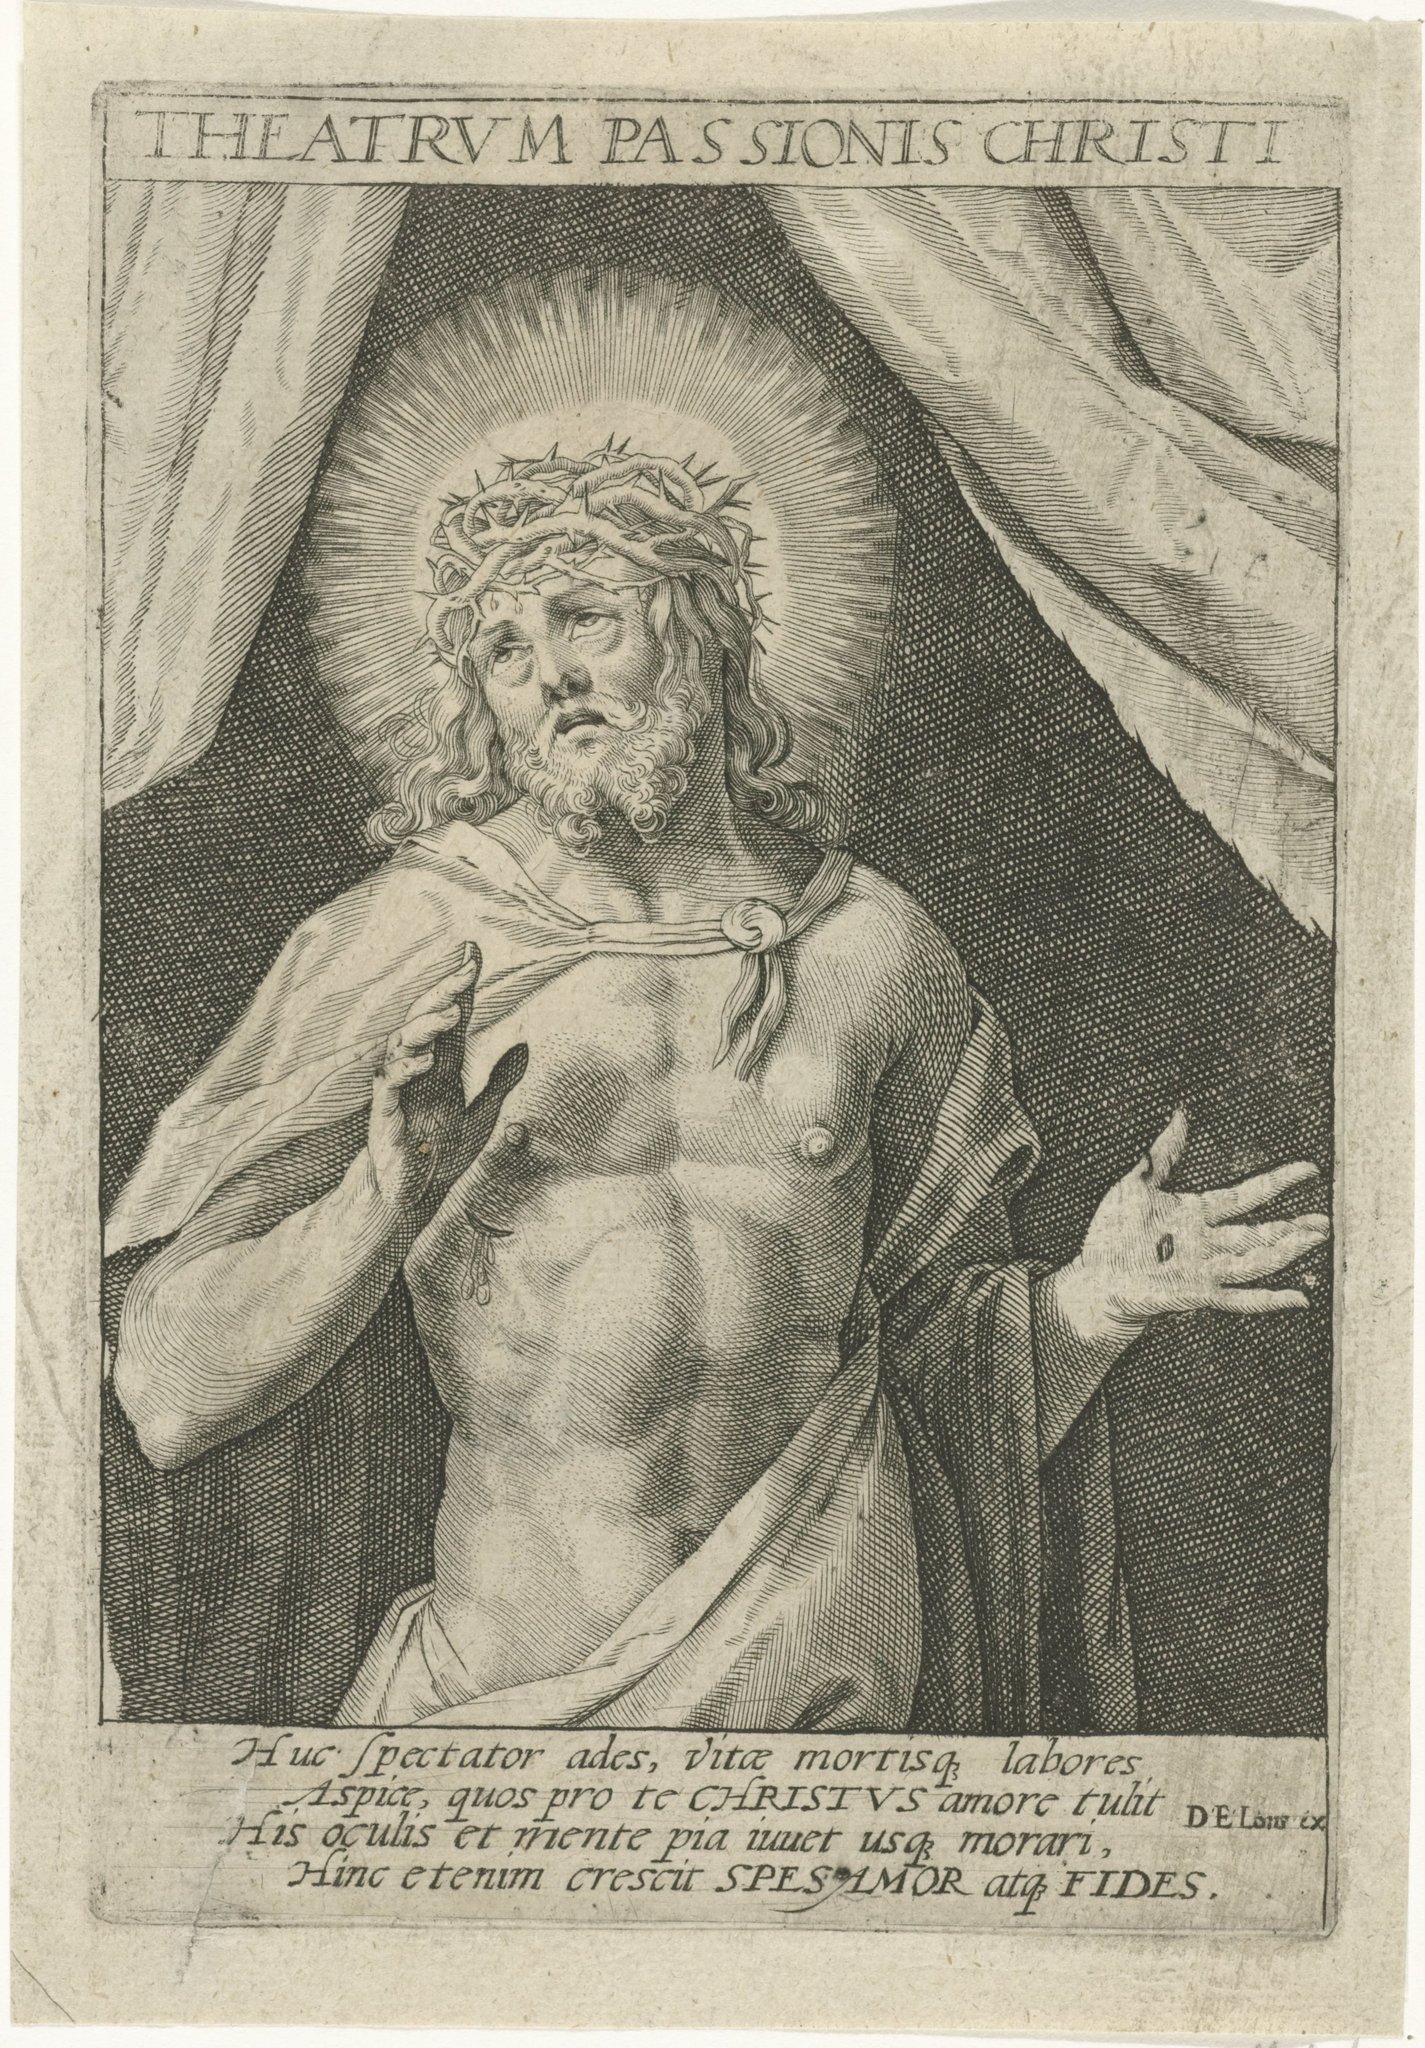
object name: print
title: Theatrvm Passionis Christi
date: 1580-1629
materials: paper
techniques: engraving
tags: man of sorrows, 'imago pietatis', 'erbärmdebild', 'schmerzensmann'; the upright christ showing his wounds, usually bearing the crown of thorns, and accompanied by the instruments of the passion, standing or sitting in his tomb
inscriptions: collector's mark: Lugt 2228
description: Christus als de Man van Smarten, met een doornenkroon op het hoofd. Titelprent van serie van prenten met de passiewerktuigen als onderwerp. De prent heeft een Latijns onderschrift